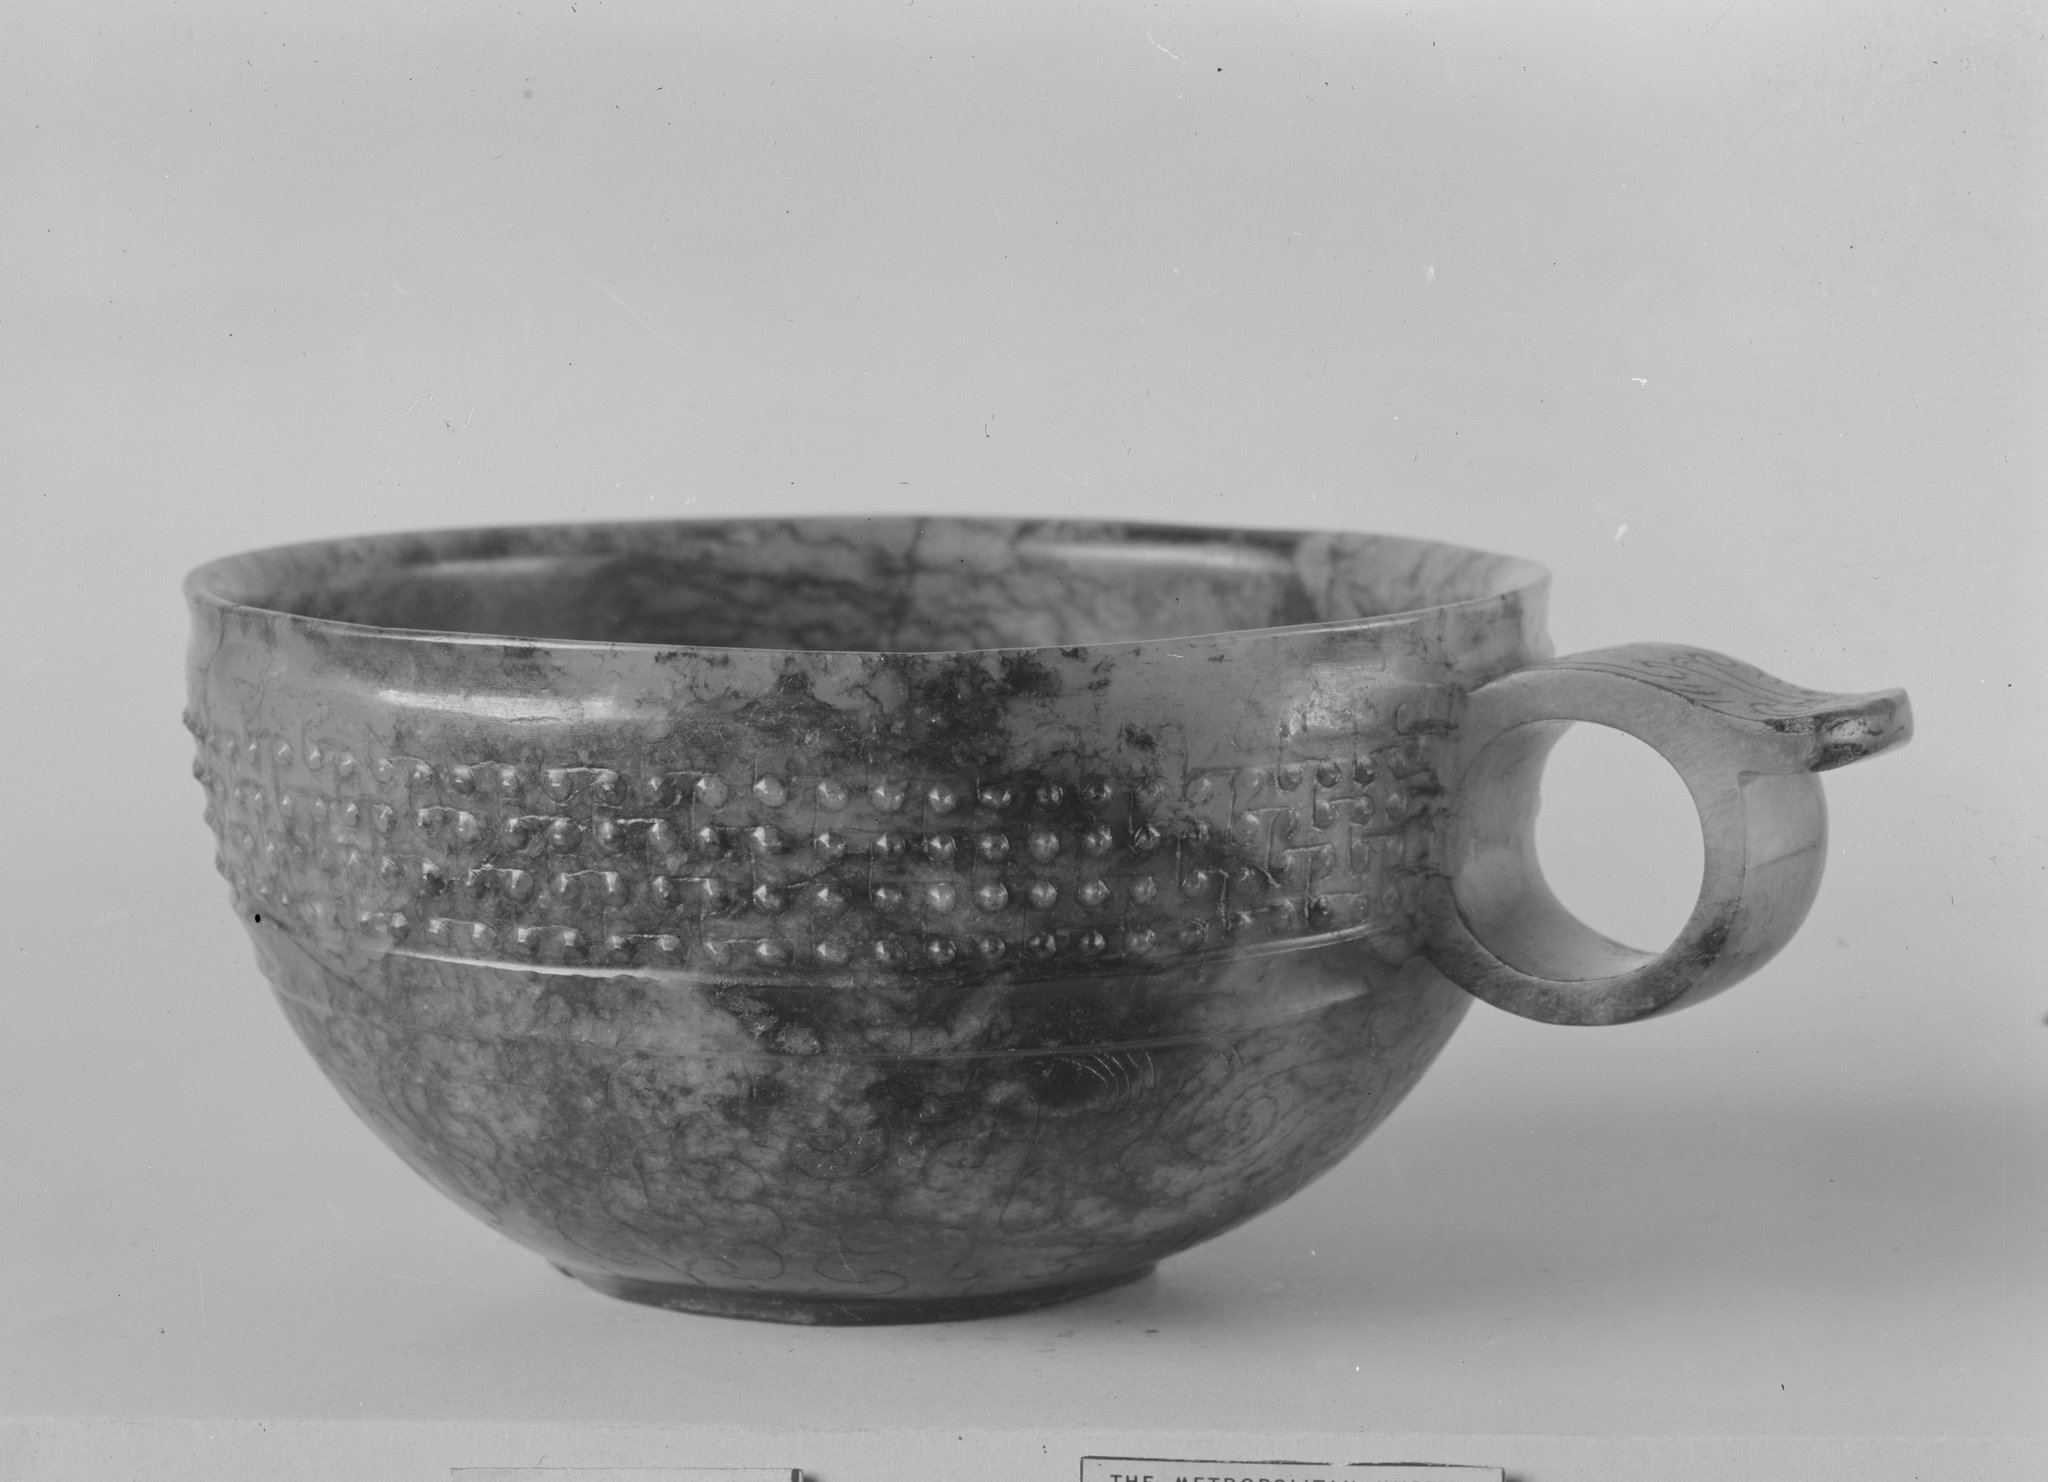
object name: cup with handle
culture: chinese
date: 960-1279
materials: jade